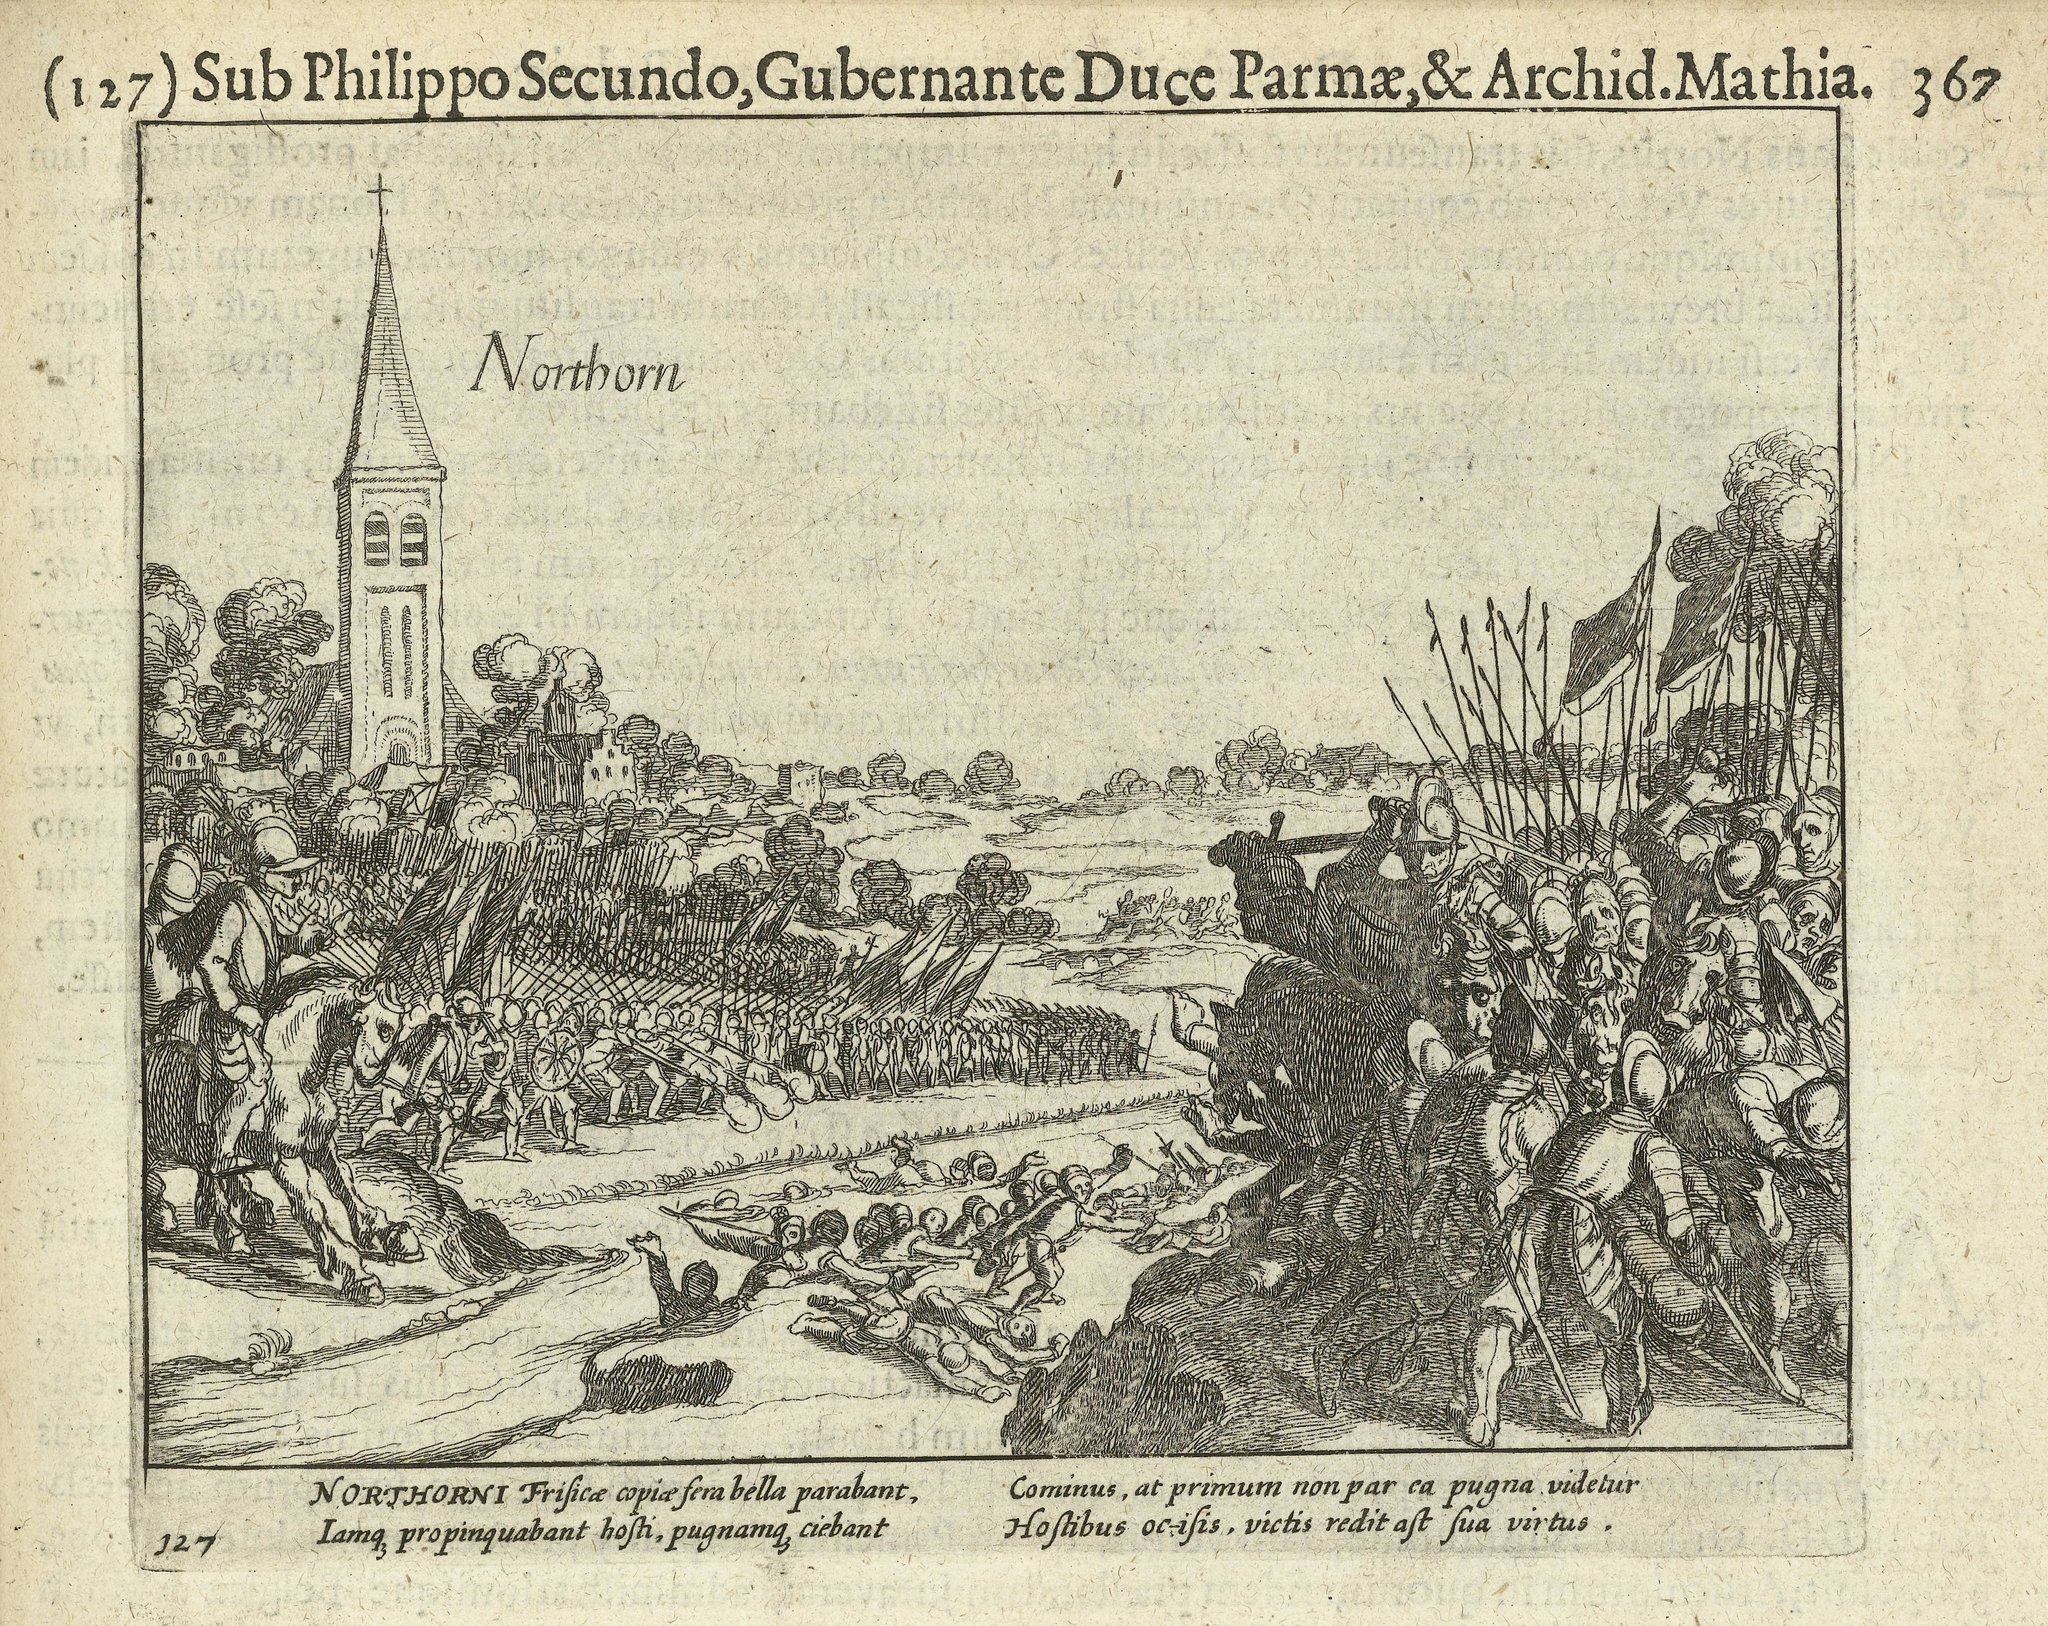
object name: history print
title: Het Staatse leger bij Noordhorn verslagen door Verdugo, 1581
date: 1613-1615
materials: paper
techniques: etching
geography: northern netherlands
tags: battle (+ land forces)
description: Het Staatse leger bij Noordhorn verslagen door de Spaanse troepen onder Verdugo, 16 september 1581. Hevige gevechten bij een rivier, links wat naar achteren de kerktoren van Noordhorn. Met onderschrift van 4 regels in het Latijn. Genummerd 127. Bedrukt op achterzijde met tekst in het Latijn.